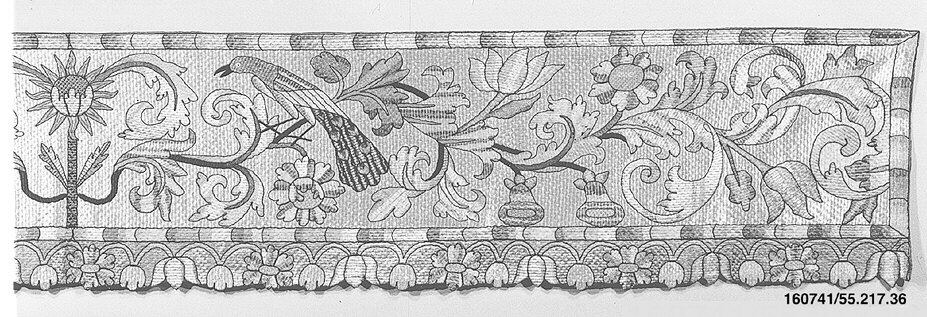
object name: valance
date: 1801-1900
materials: metal thread, silk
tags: birds,flowers